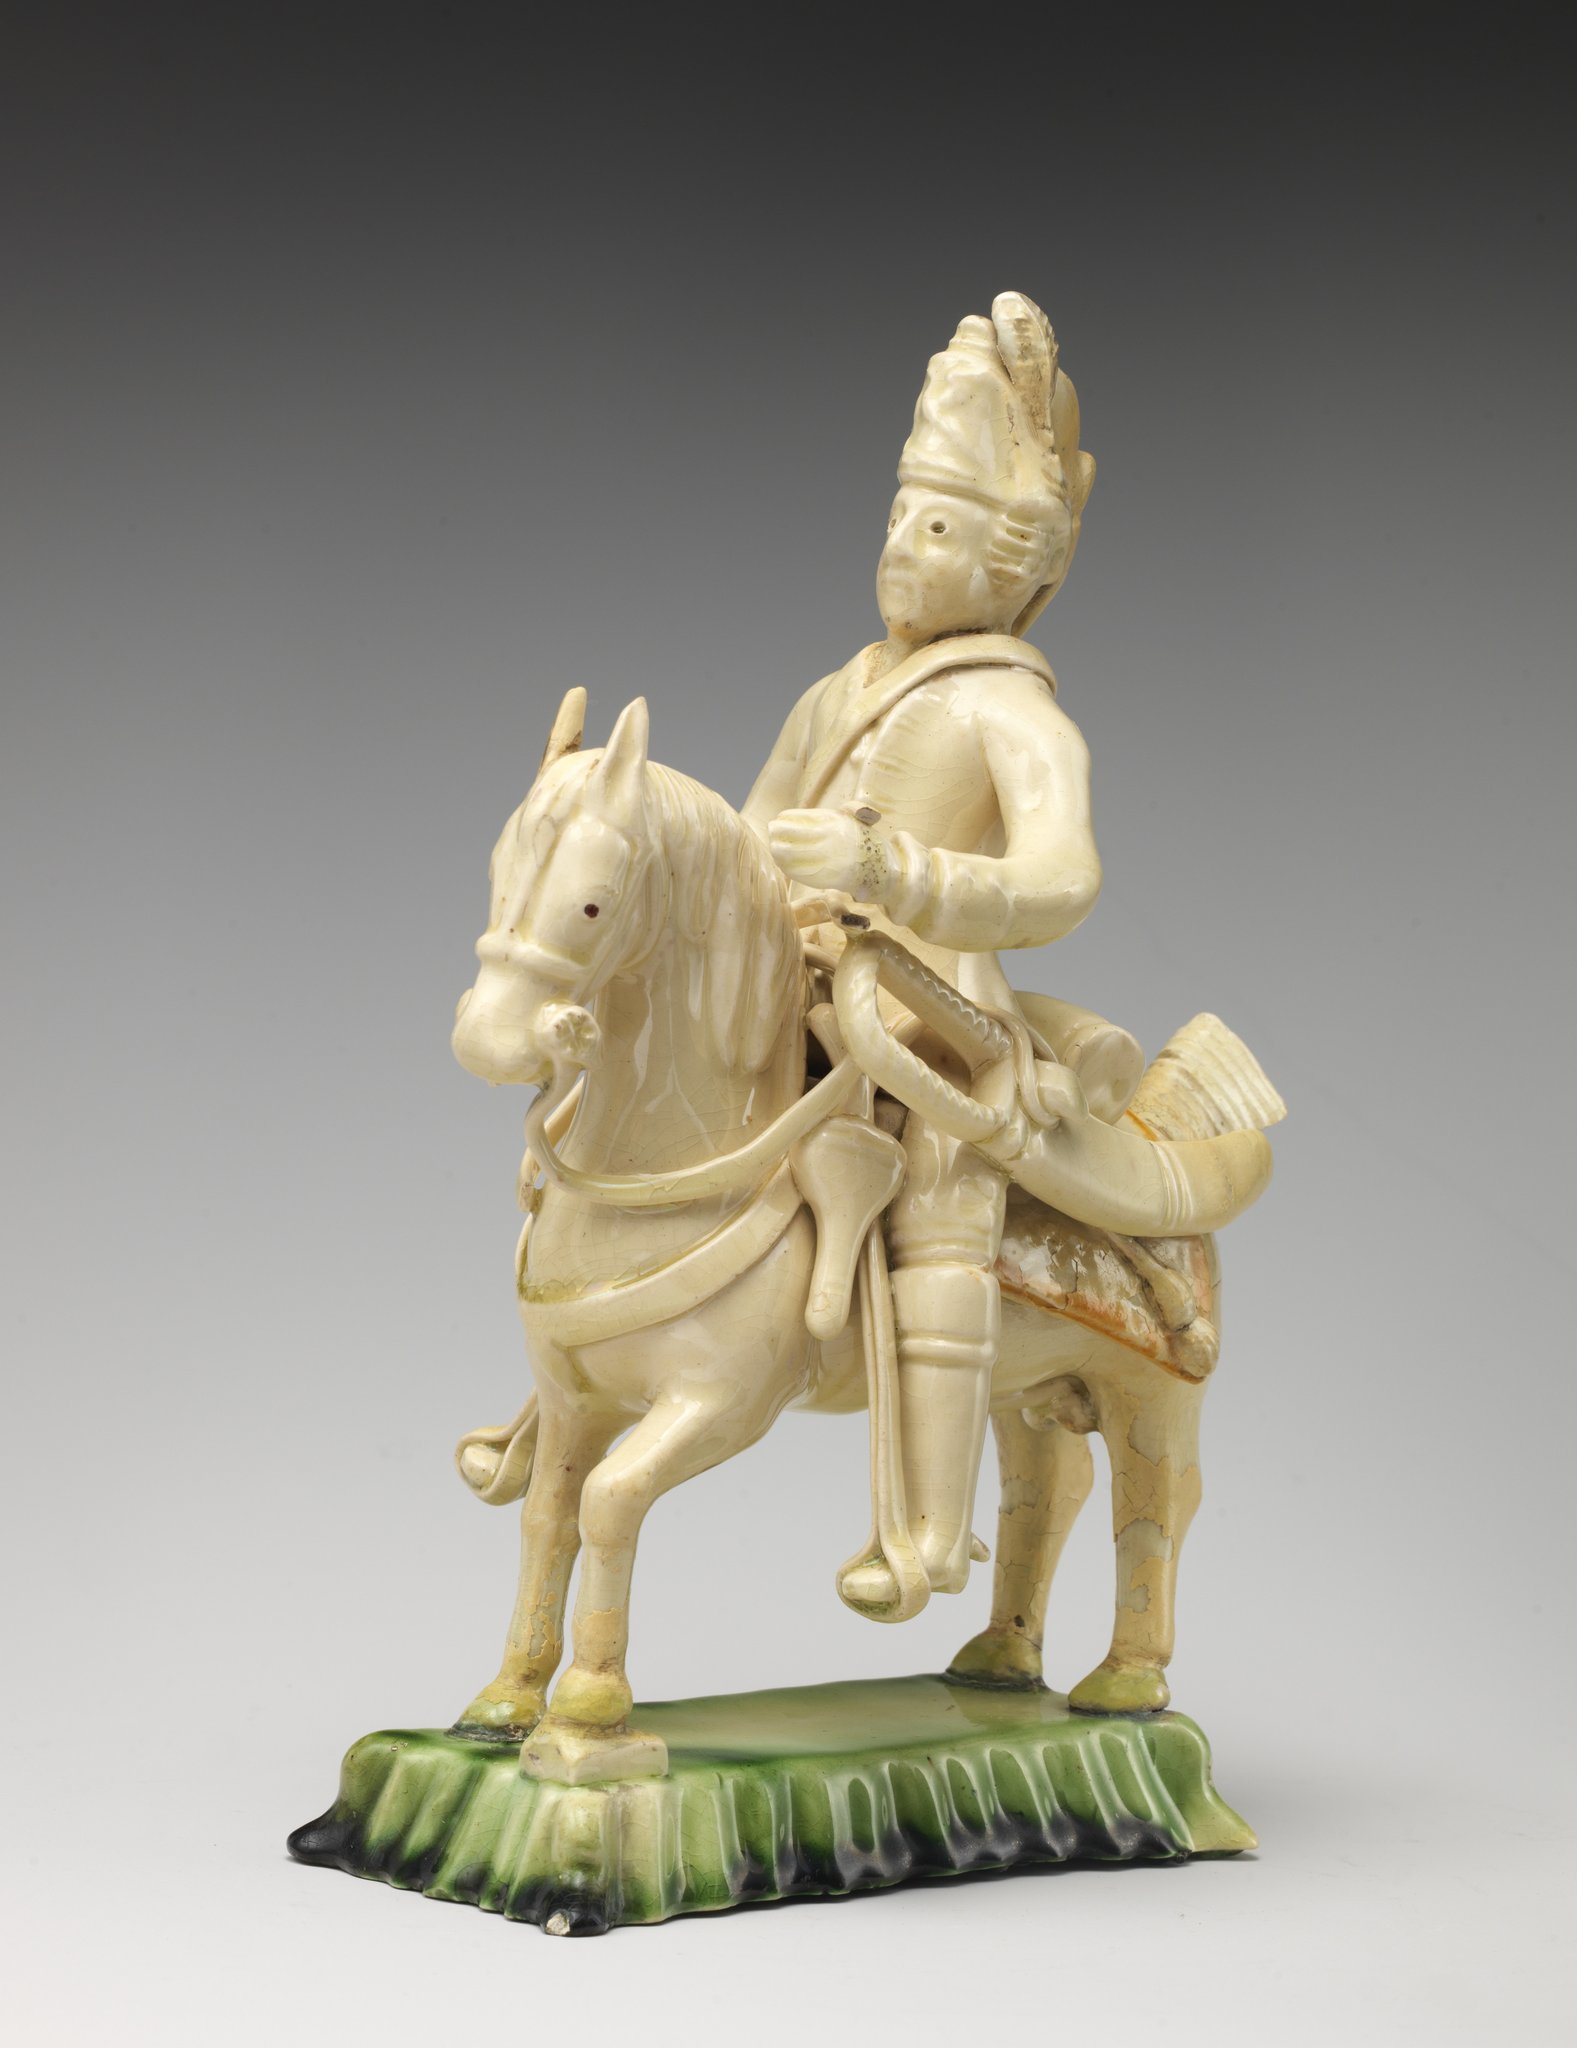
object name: figure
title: Mounted soldier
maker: john astbury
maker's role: maker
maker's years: 1688-1743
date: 1701-1800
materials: earthenware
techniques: glazing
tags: soldiers,swords,horses